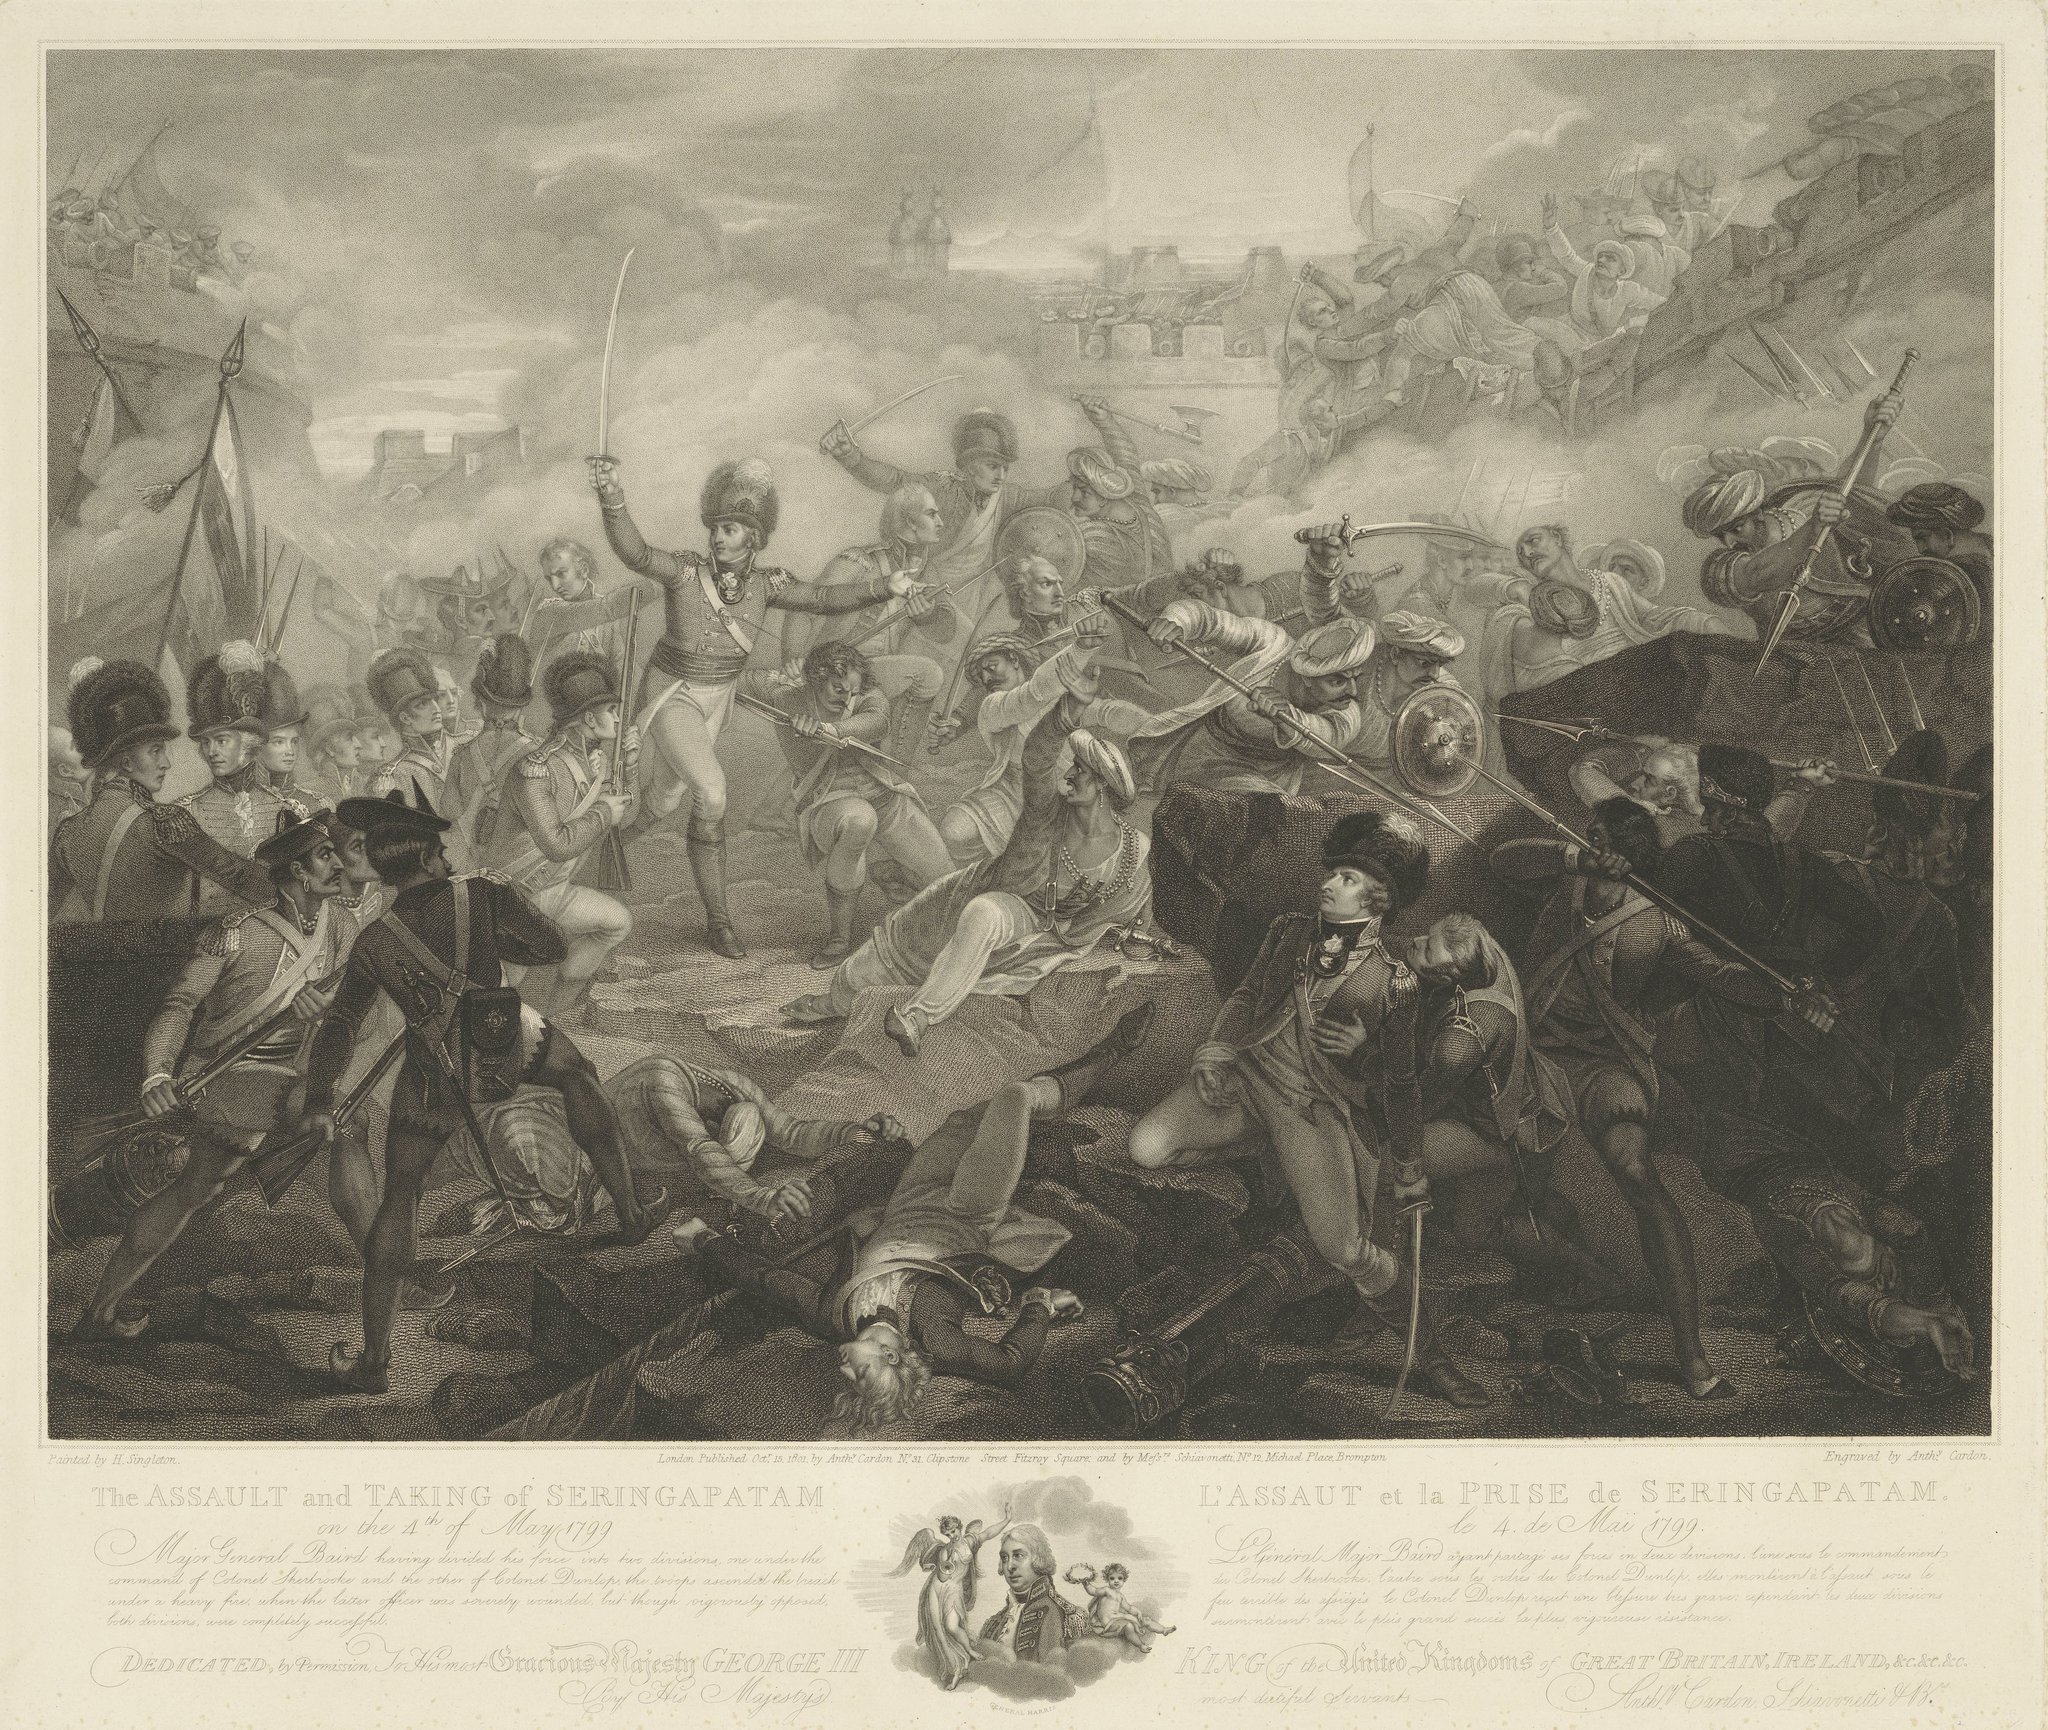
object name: print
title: Aanval op Seringapatam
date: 1801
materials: paper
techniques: engraving, etching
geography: netherlands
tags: historical persons, assault ~ siege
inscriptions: collector's mark: ‘AC’, collector's mark: Lugt 12